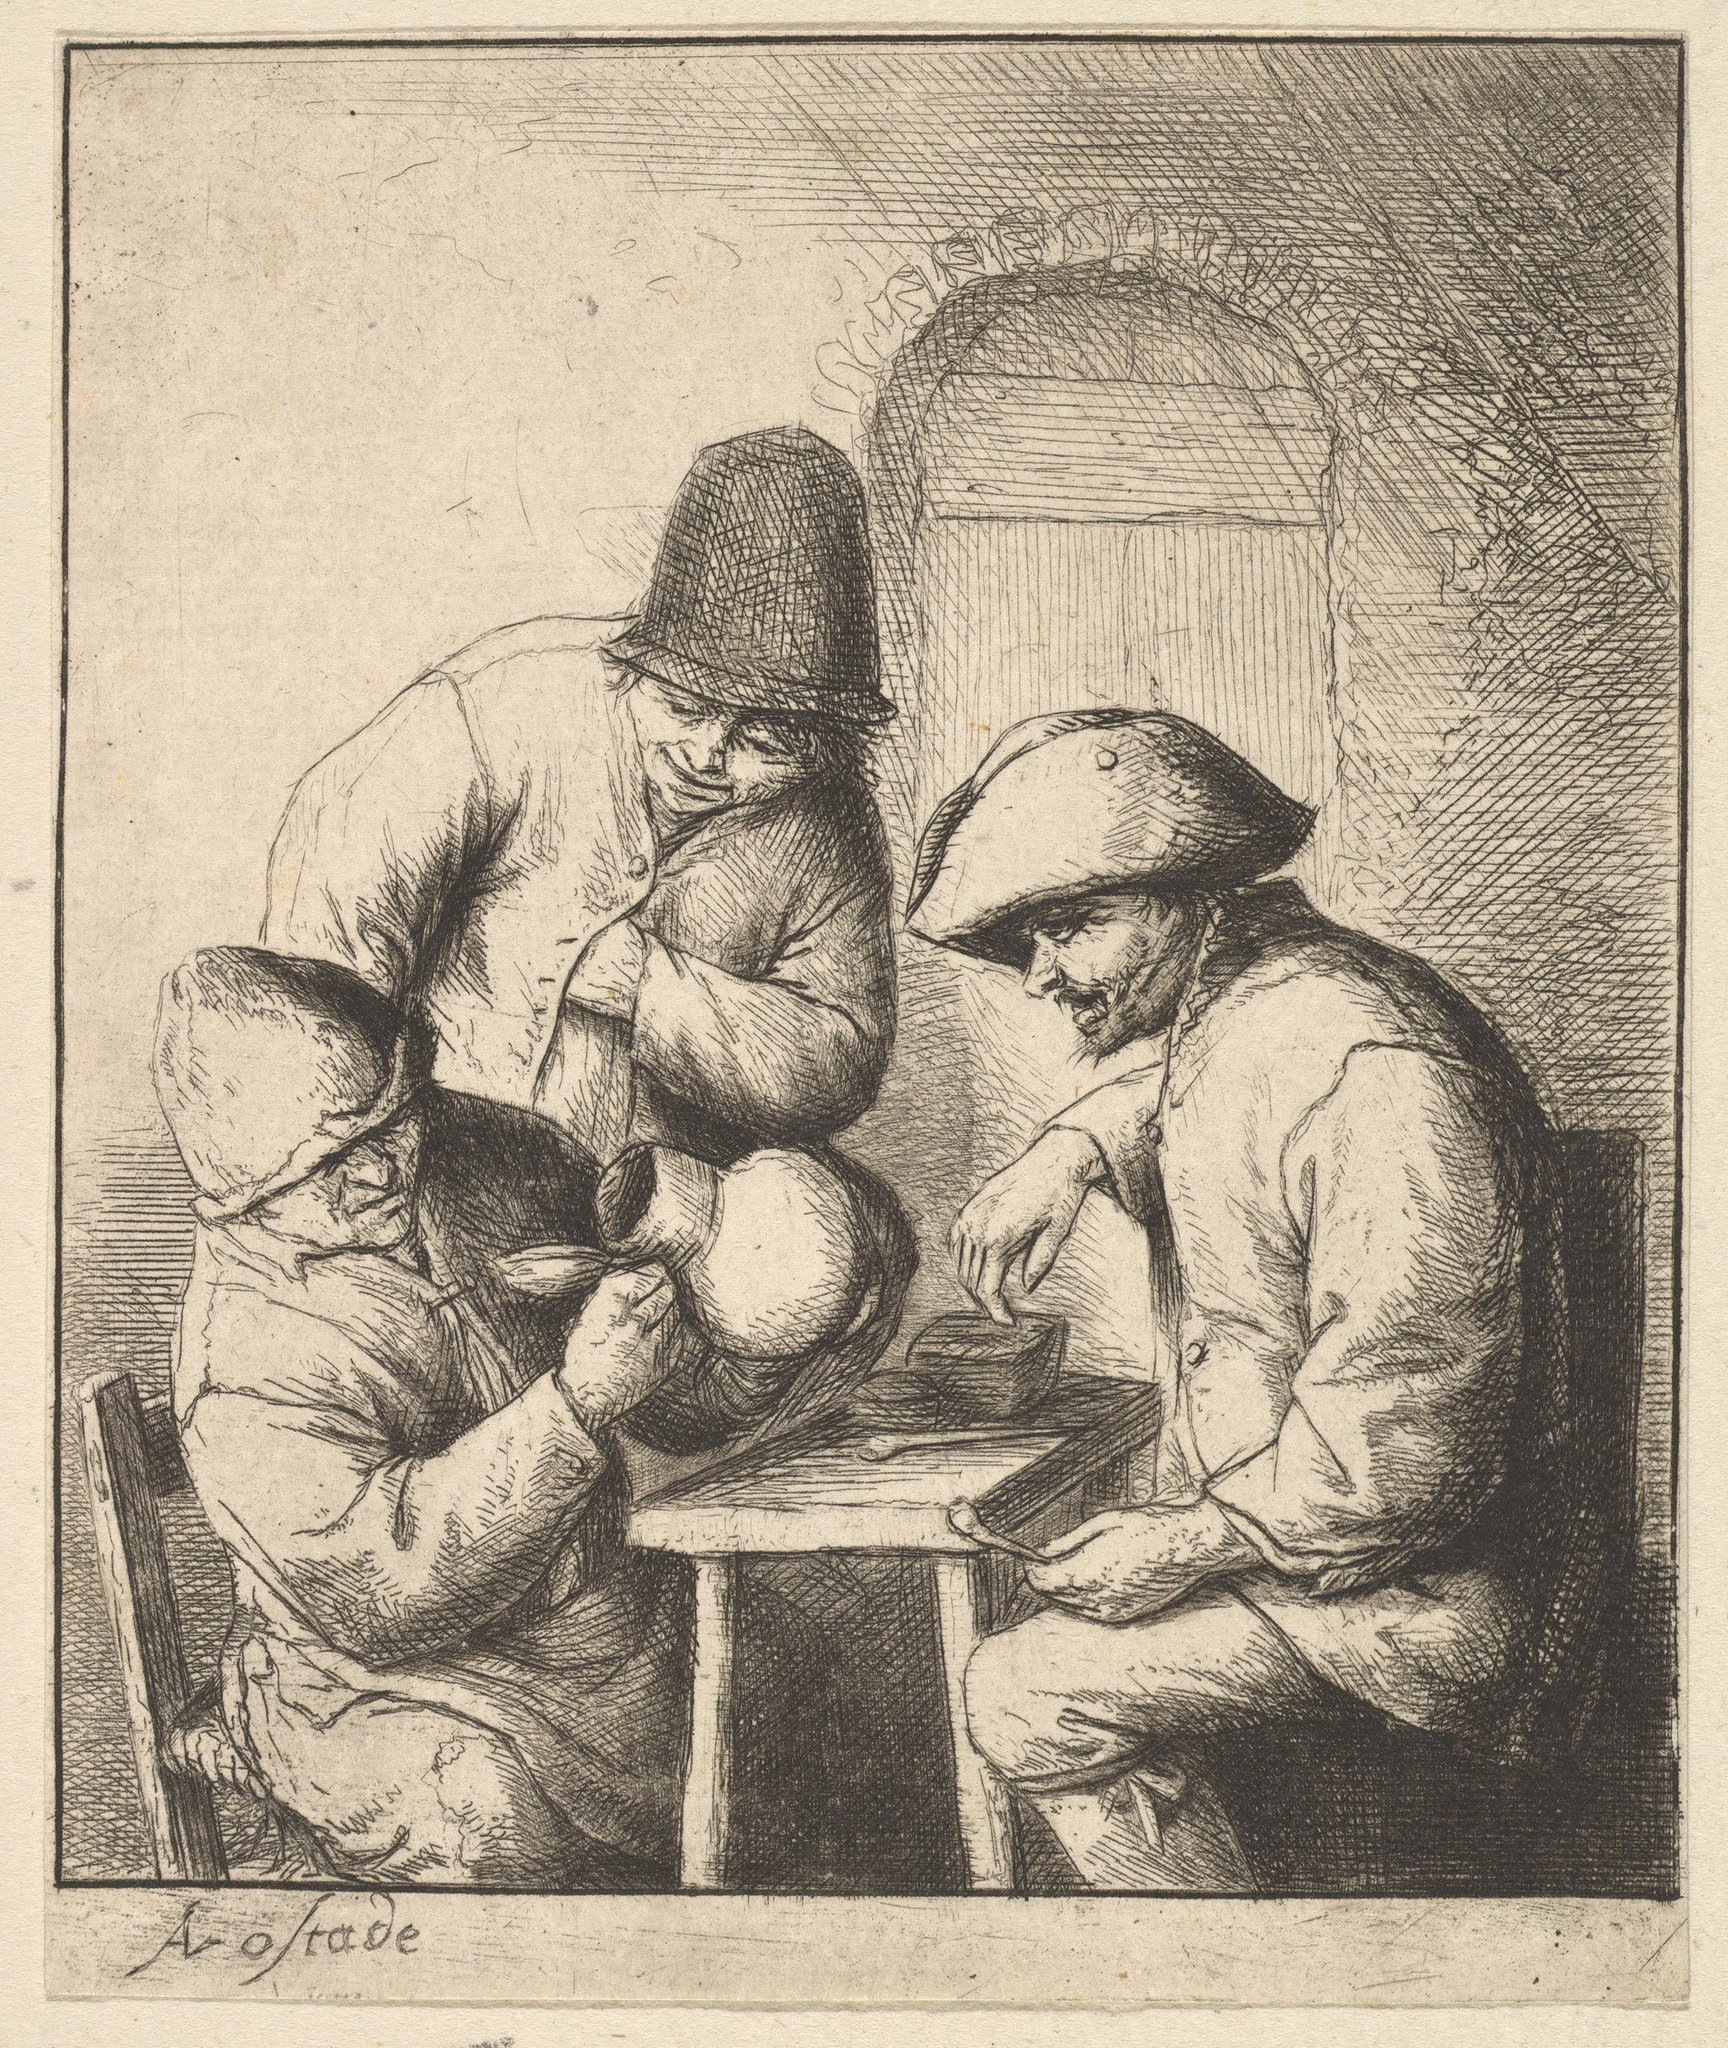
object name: print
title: Empty Jug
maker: adriaen van ostade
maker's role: artist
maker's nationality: dutch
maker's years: 1610-1685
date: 1610-1685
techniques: etching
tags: men,jugs